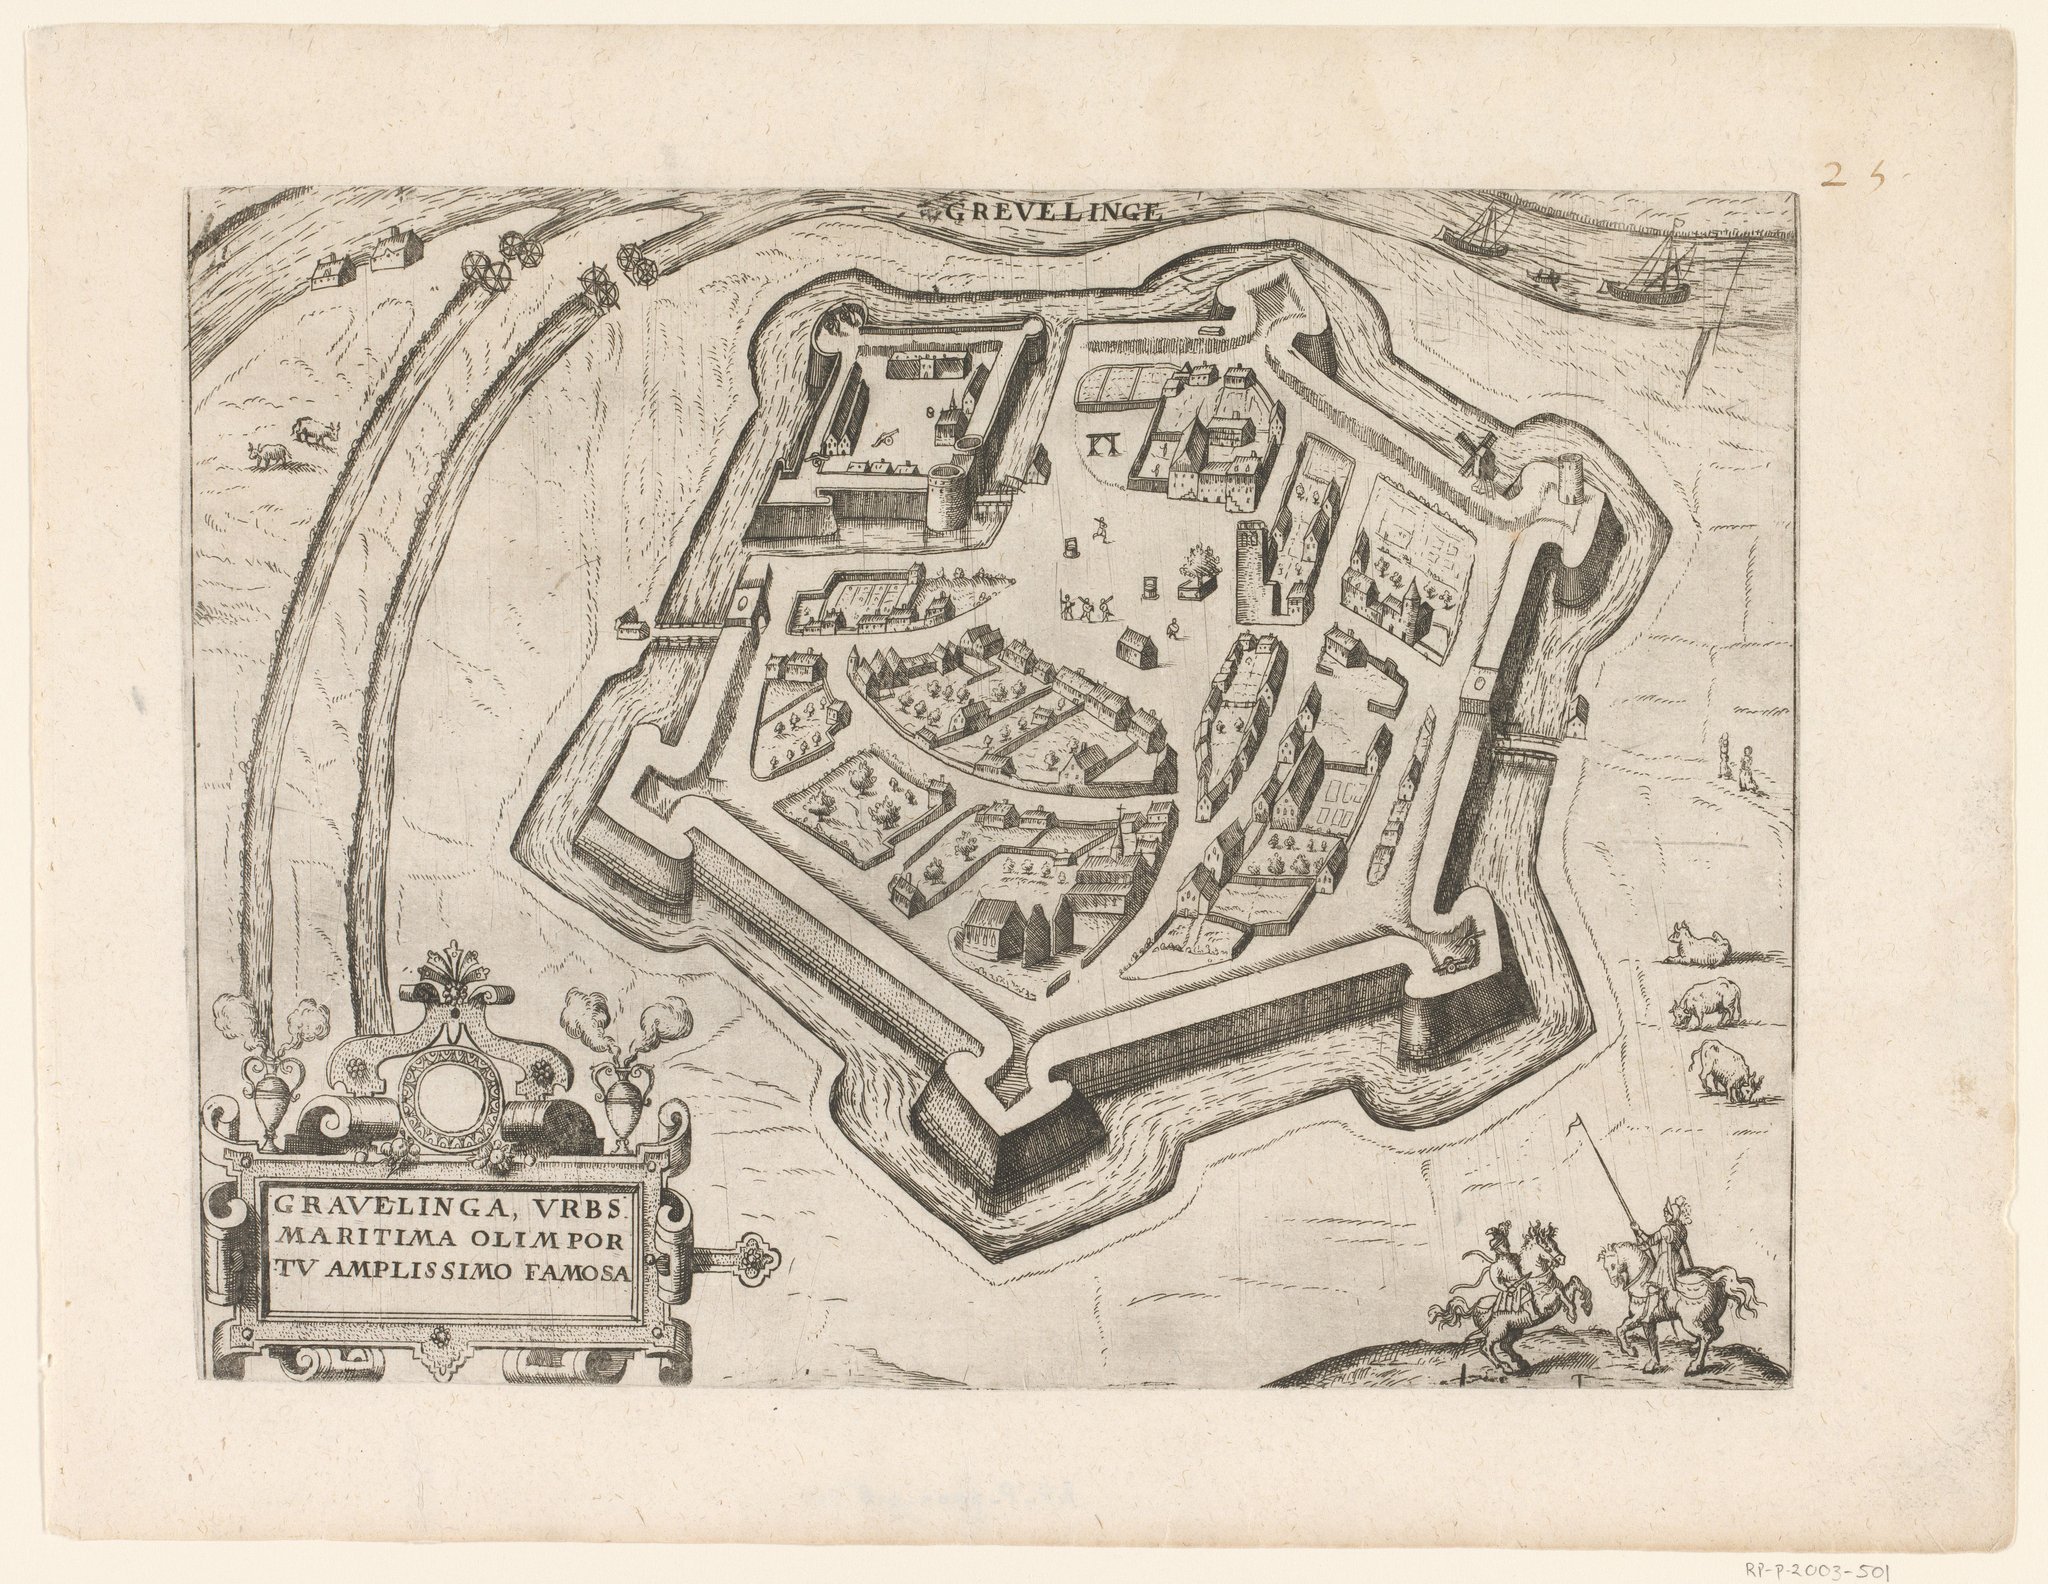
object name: area plan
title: Plattegrond van Grevelingen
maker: Anonymous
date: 1607-1609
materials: paper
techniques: etching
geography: northern netherlands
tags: maps of cities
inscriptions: number: ‘25’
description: Plattegrond van de stad Grevelingen (Gravelines). Midden boven de titel, linksonder een cartouche met de Latijnse titel. Rechtsonder twee ruiters. Onderdeel van de verzameling kaarten genomen uit een latere editie van: Descrittione di tutti i Paesi Bassi van Lodovico Guicciardini.